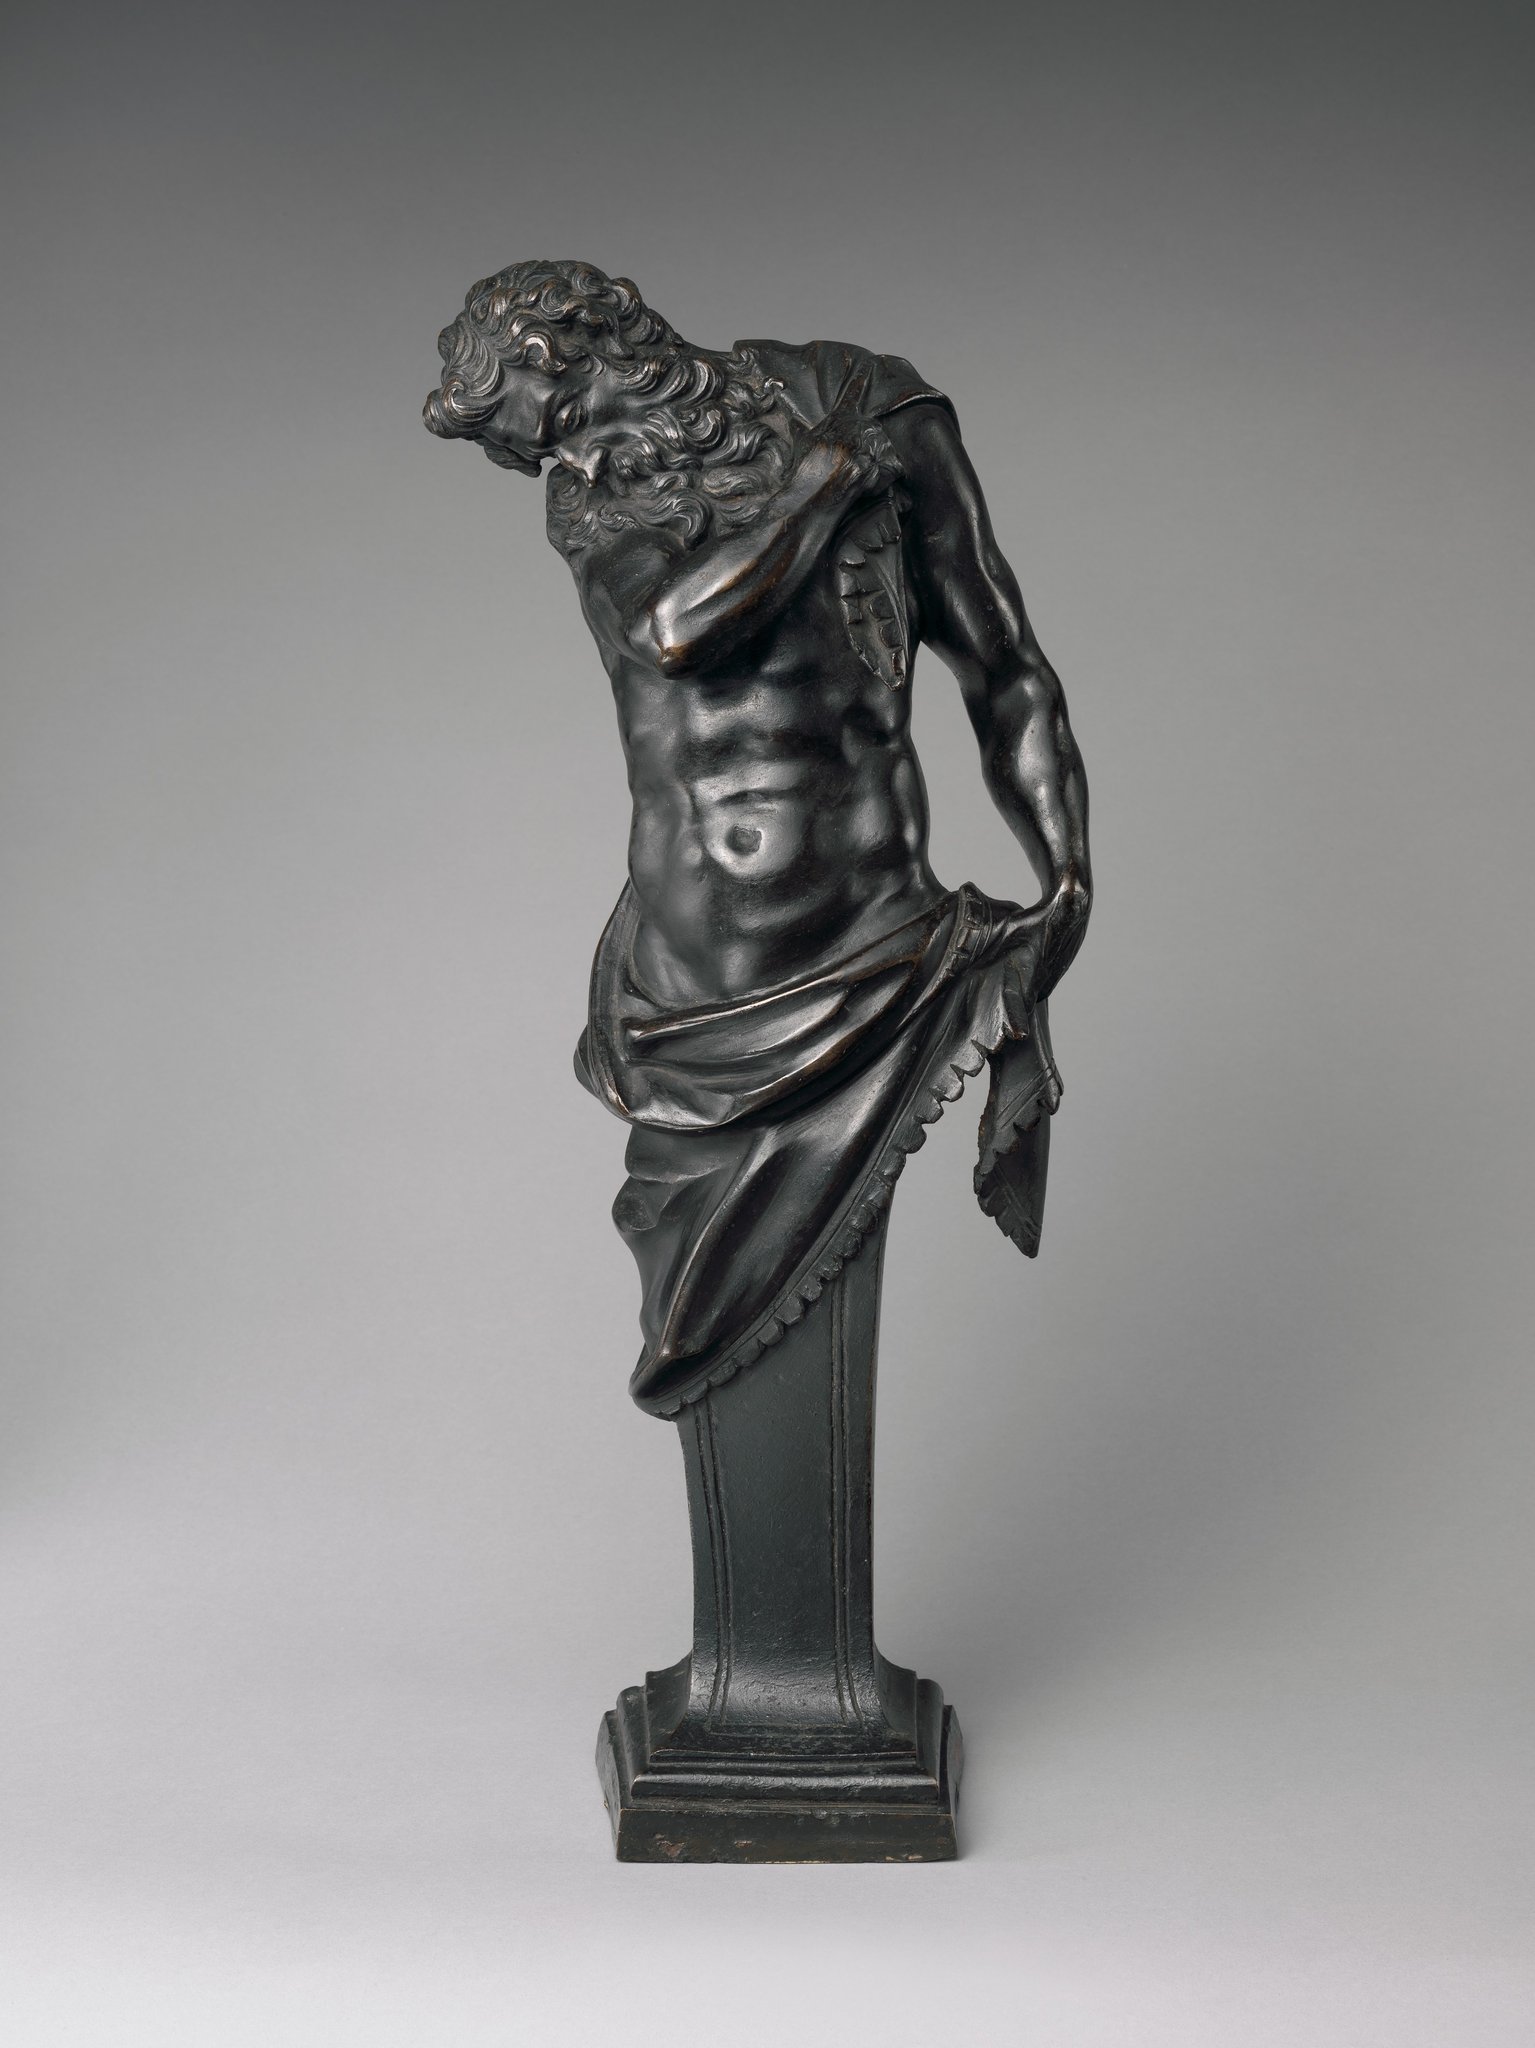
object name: term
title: Male term figure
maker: annibale fontana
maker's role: artist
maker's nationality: italian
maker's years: 1540-1587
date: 1667-1700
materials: bronze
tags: men,hermes